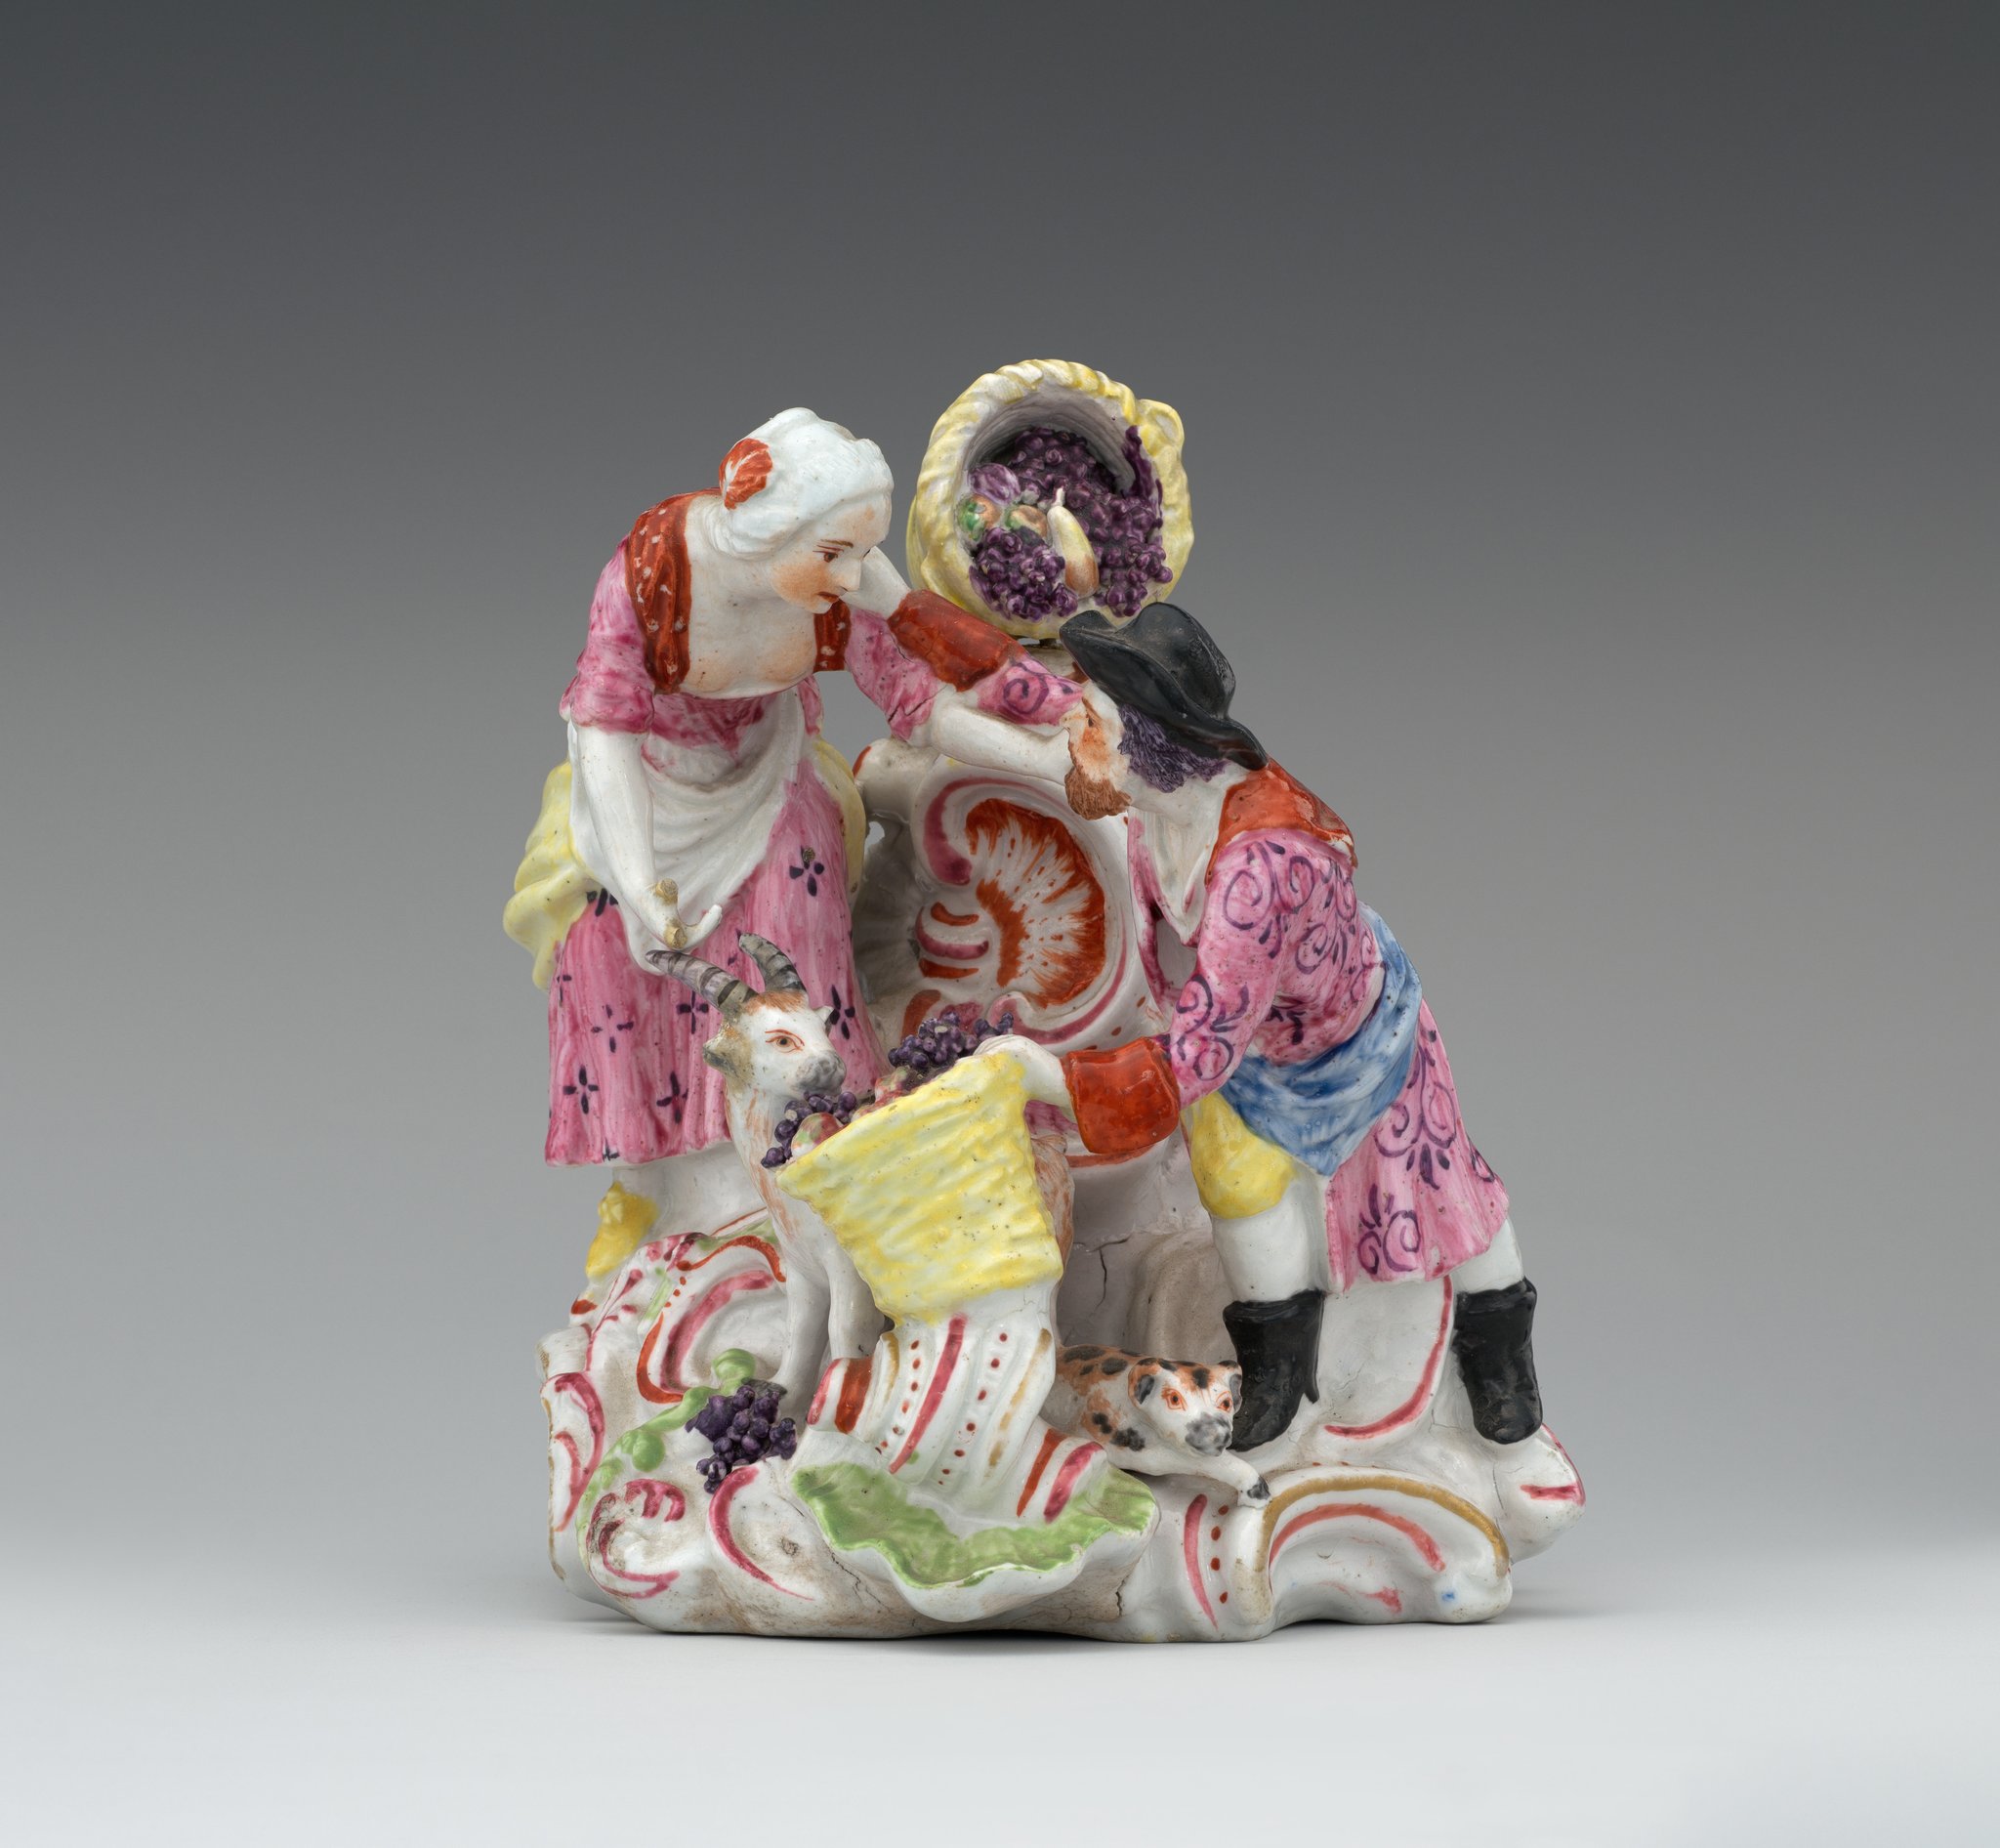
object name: group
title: Vintners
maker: longton hall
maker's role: factory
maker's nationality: british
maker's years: 1744-1760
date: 1755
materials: soft paste porcelain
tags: grapes,men,women,dogs,goats